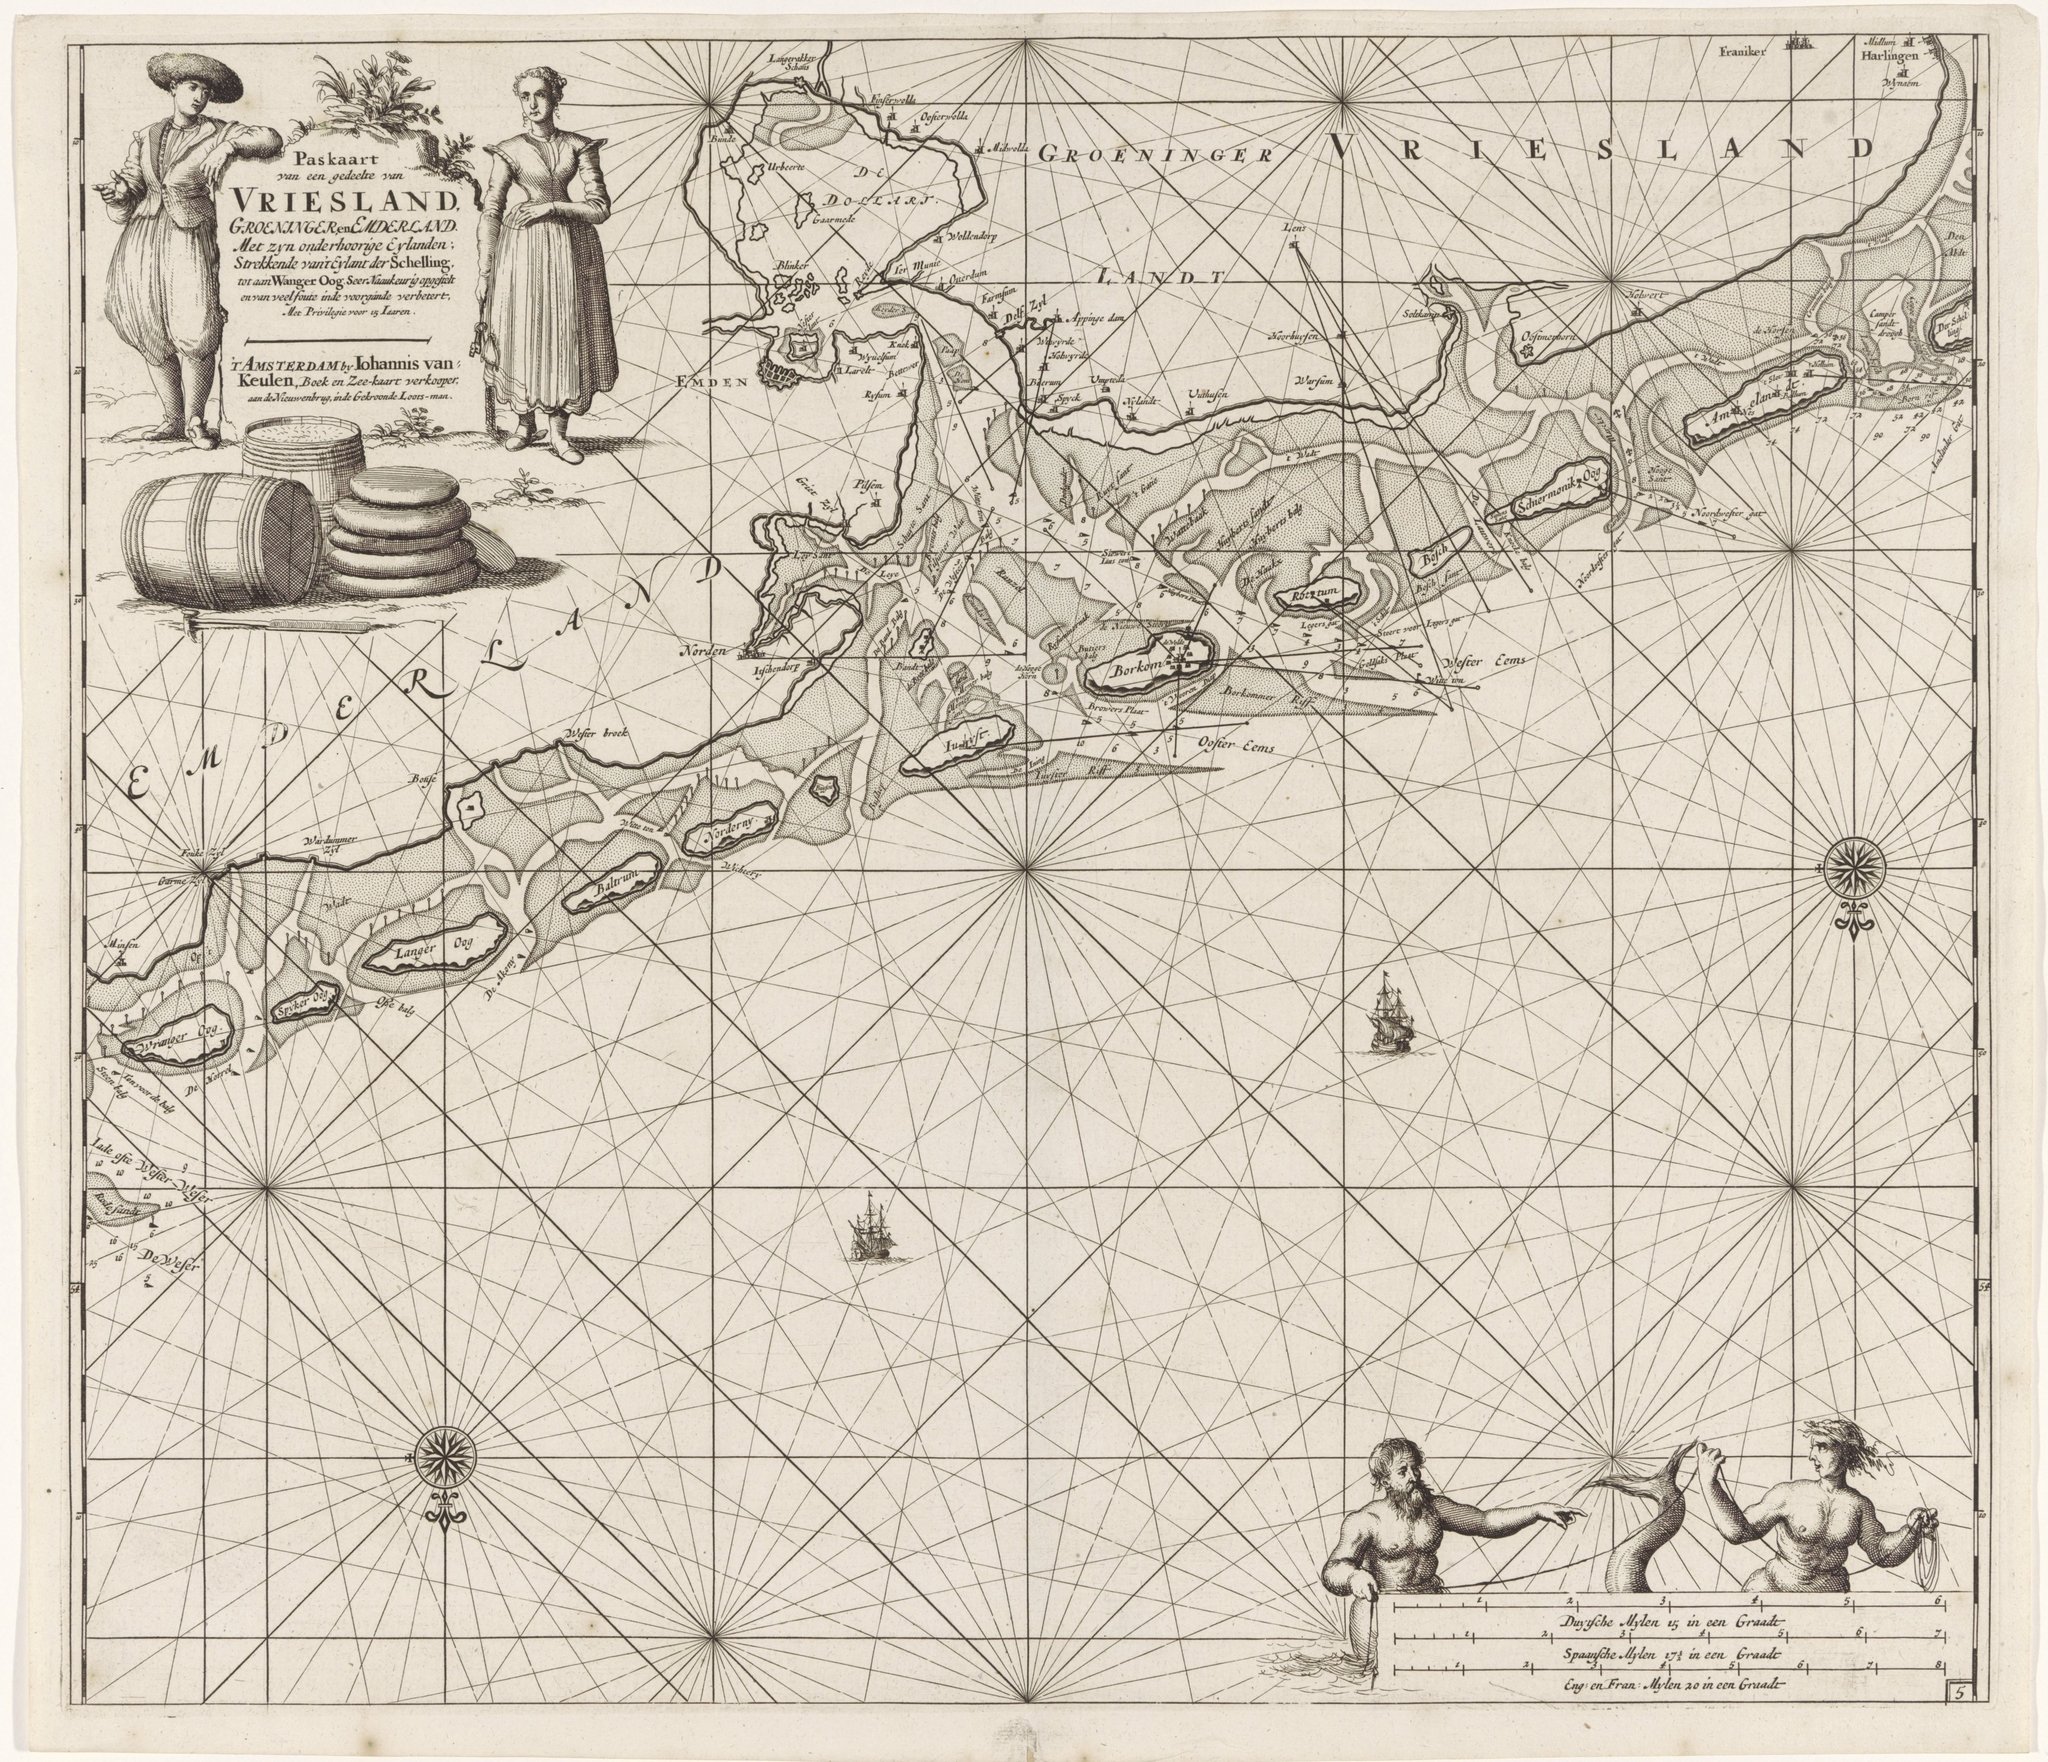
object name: print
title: Paskaart van een gedeelte van Vriesland, Groeninger, en Emderland met zyn onderhoorige Eylanden; Strekkende van 't Eylant der Schelling, tot aan Wanger Oog. Seer Naaukeurig opgestelt en van veel foute inde voorgande verbetert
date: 1681-1799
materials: paper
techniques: engraving, etching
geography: amsterdam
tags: merman, merman - aa - mermaid, siren, key, seaman, cheese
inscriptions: collector's mark: Lugt 2228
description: Paskaart van de Nederlandse en Duitse Waddeneilanden, Friesland en Groningen, vanaf Terschelling tot Wangerooge, met twee kompasrozen, het Noorden ligt onder. Linksboven een cartouche met de titel en het adres van de uitgever, geflankeerd door een Friese vrouw en een zeeman. Onder het adres twee vaten en een stapel kazen. Rechtsonder een meerman en een zeemeermin met een lijn bij de schaal in Duitse, Spaanse en Engelse of Franse mijlen.